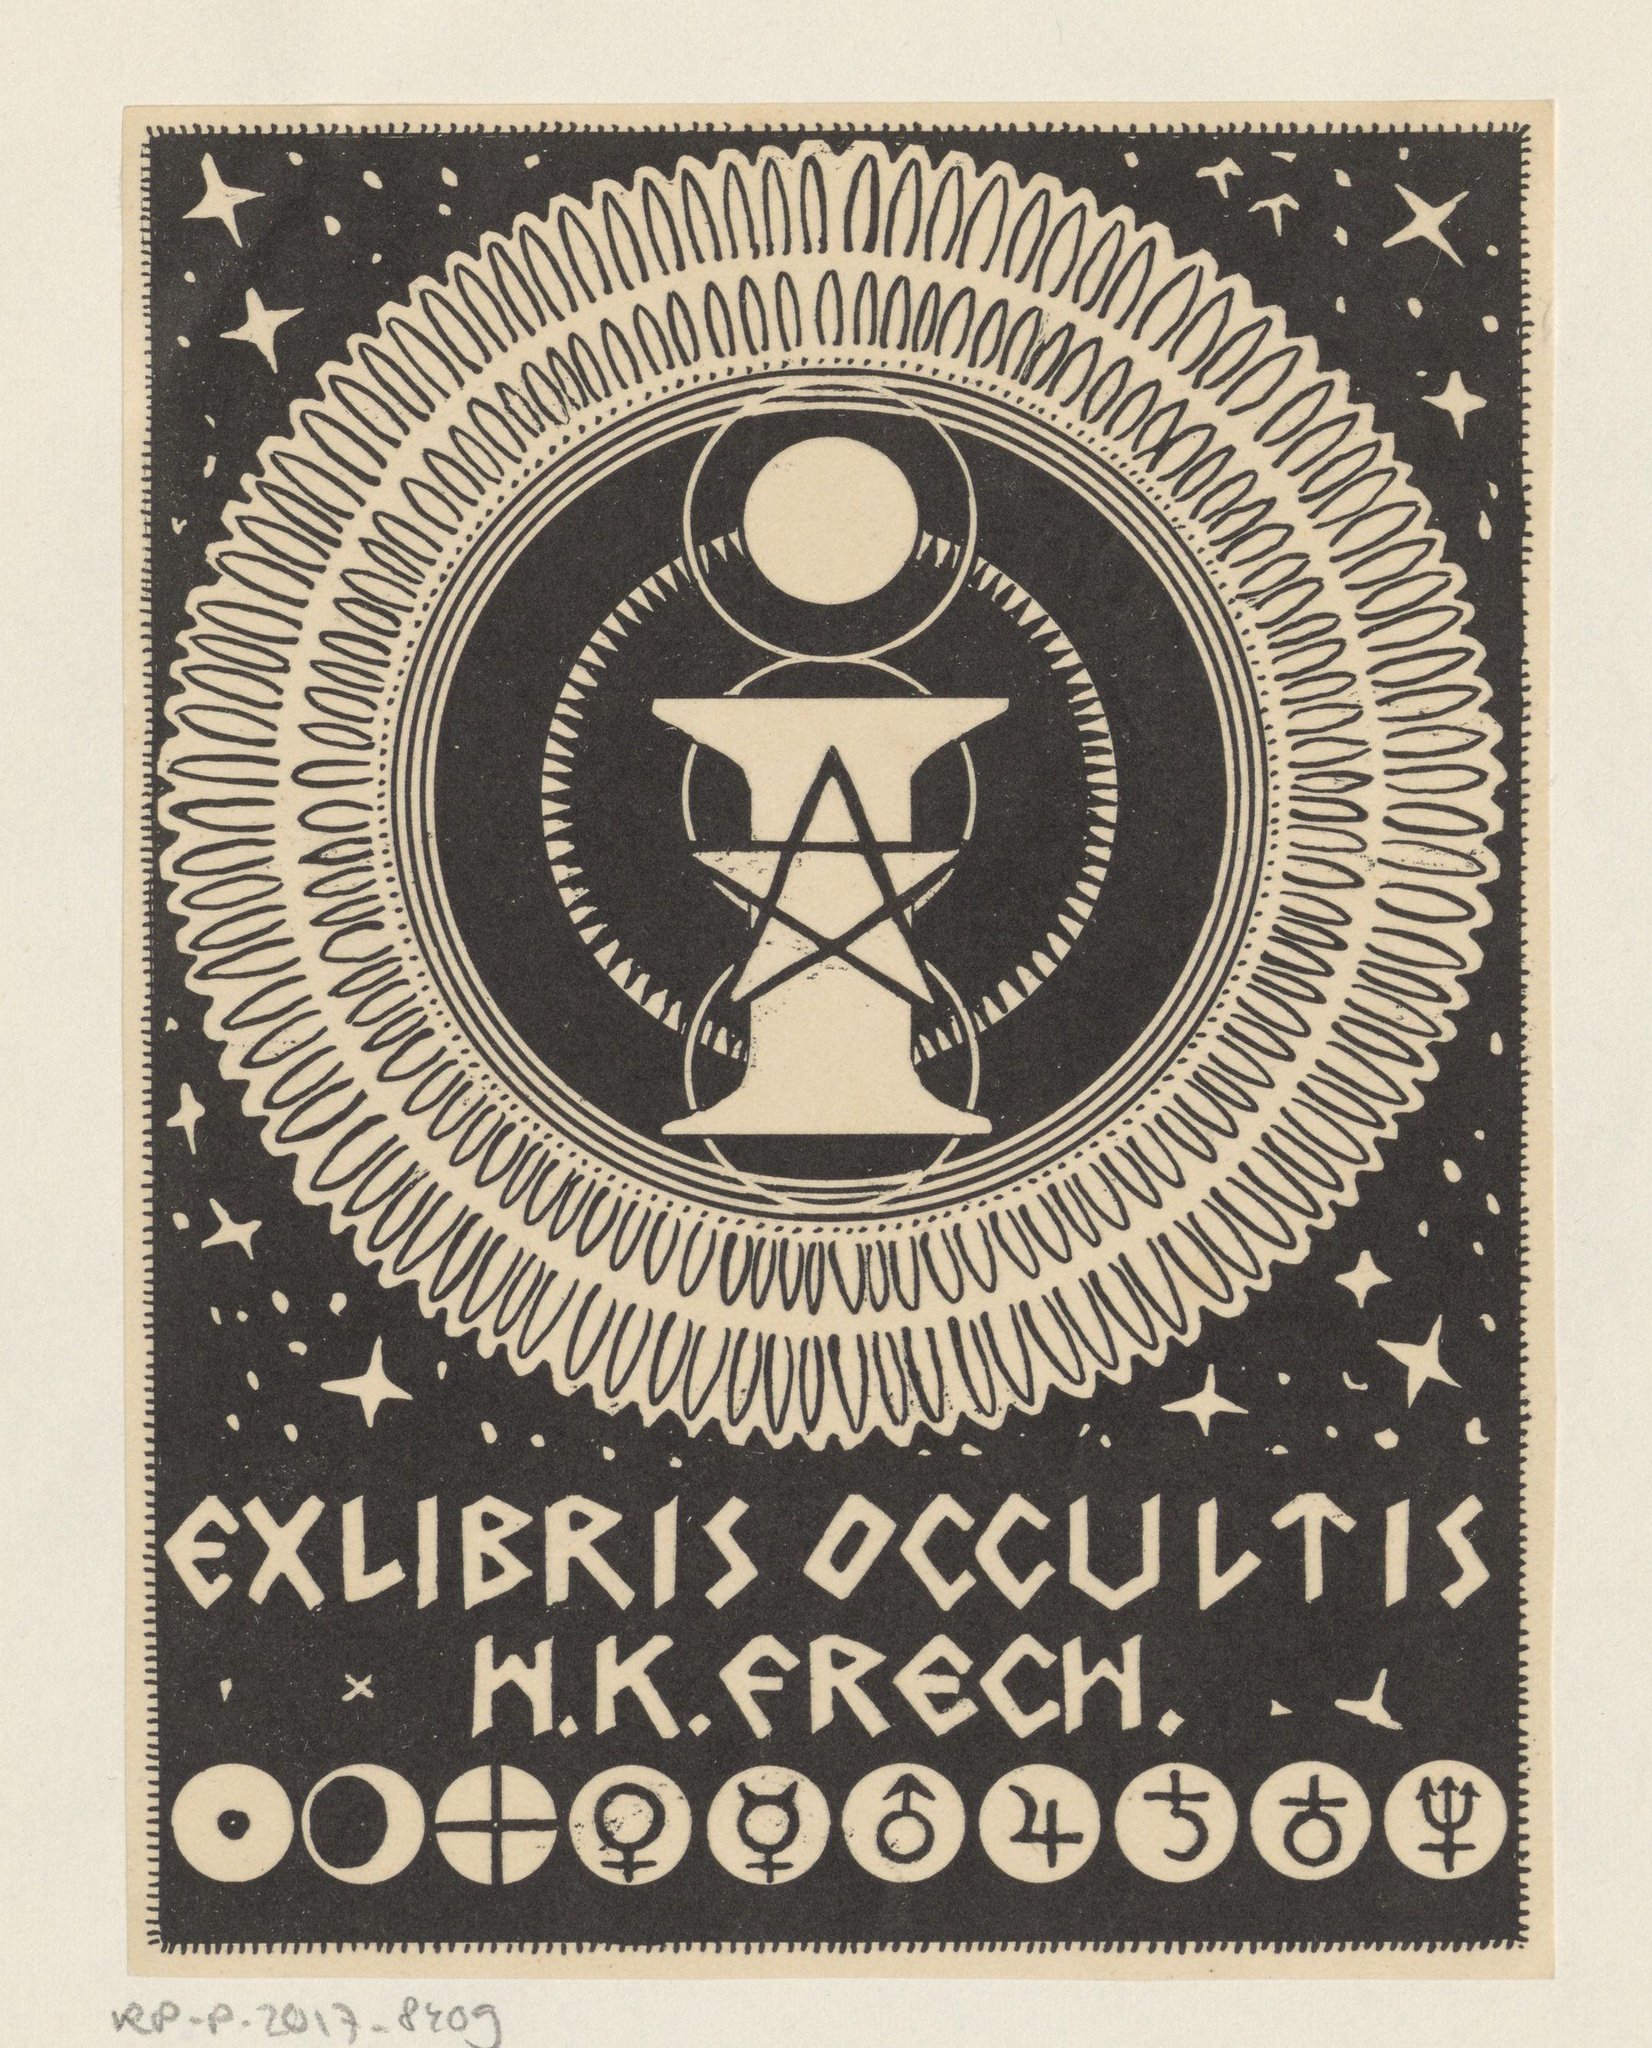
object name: bookplate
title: Ex libris occultis H.K. Frech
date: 1893-1945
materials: paper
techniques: printing block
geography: bratislava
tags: magic, supernaturalism, occultism, stars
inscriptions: workshop stamp: ‘Karl Frech/ Maler-Graphiker/ Bratislava - Pressburg Simonyi Ivan Rad.’